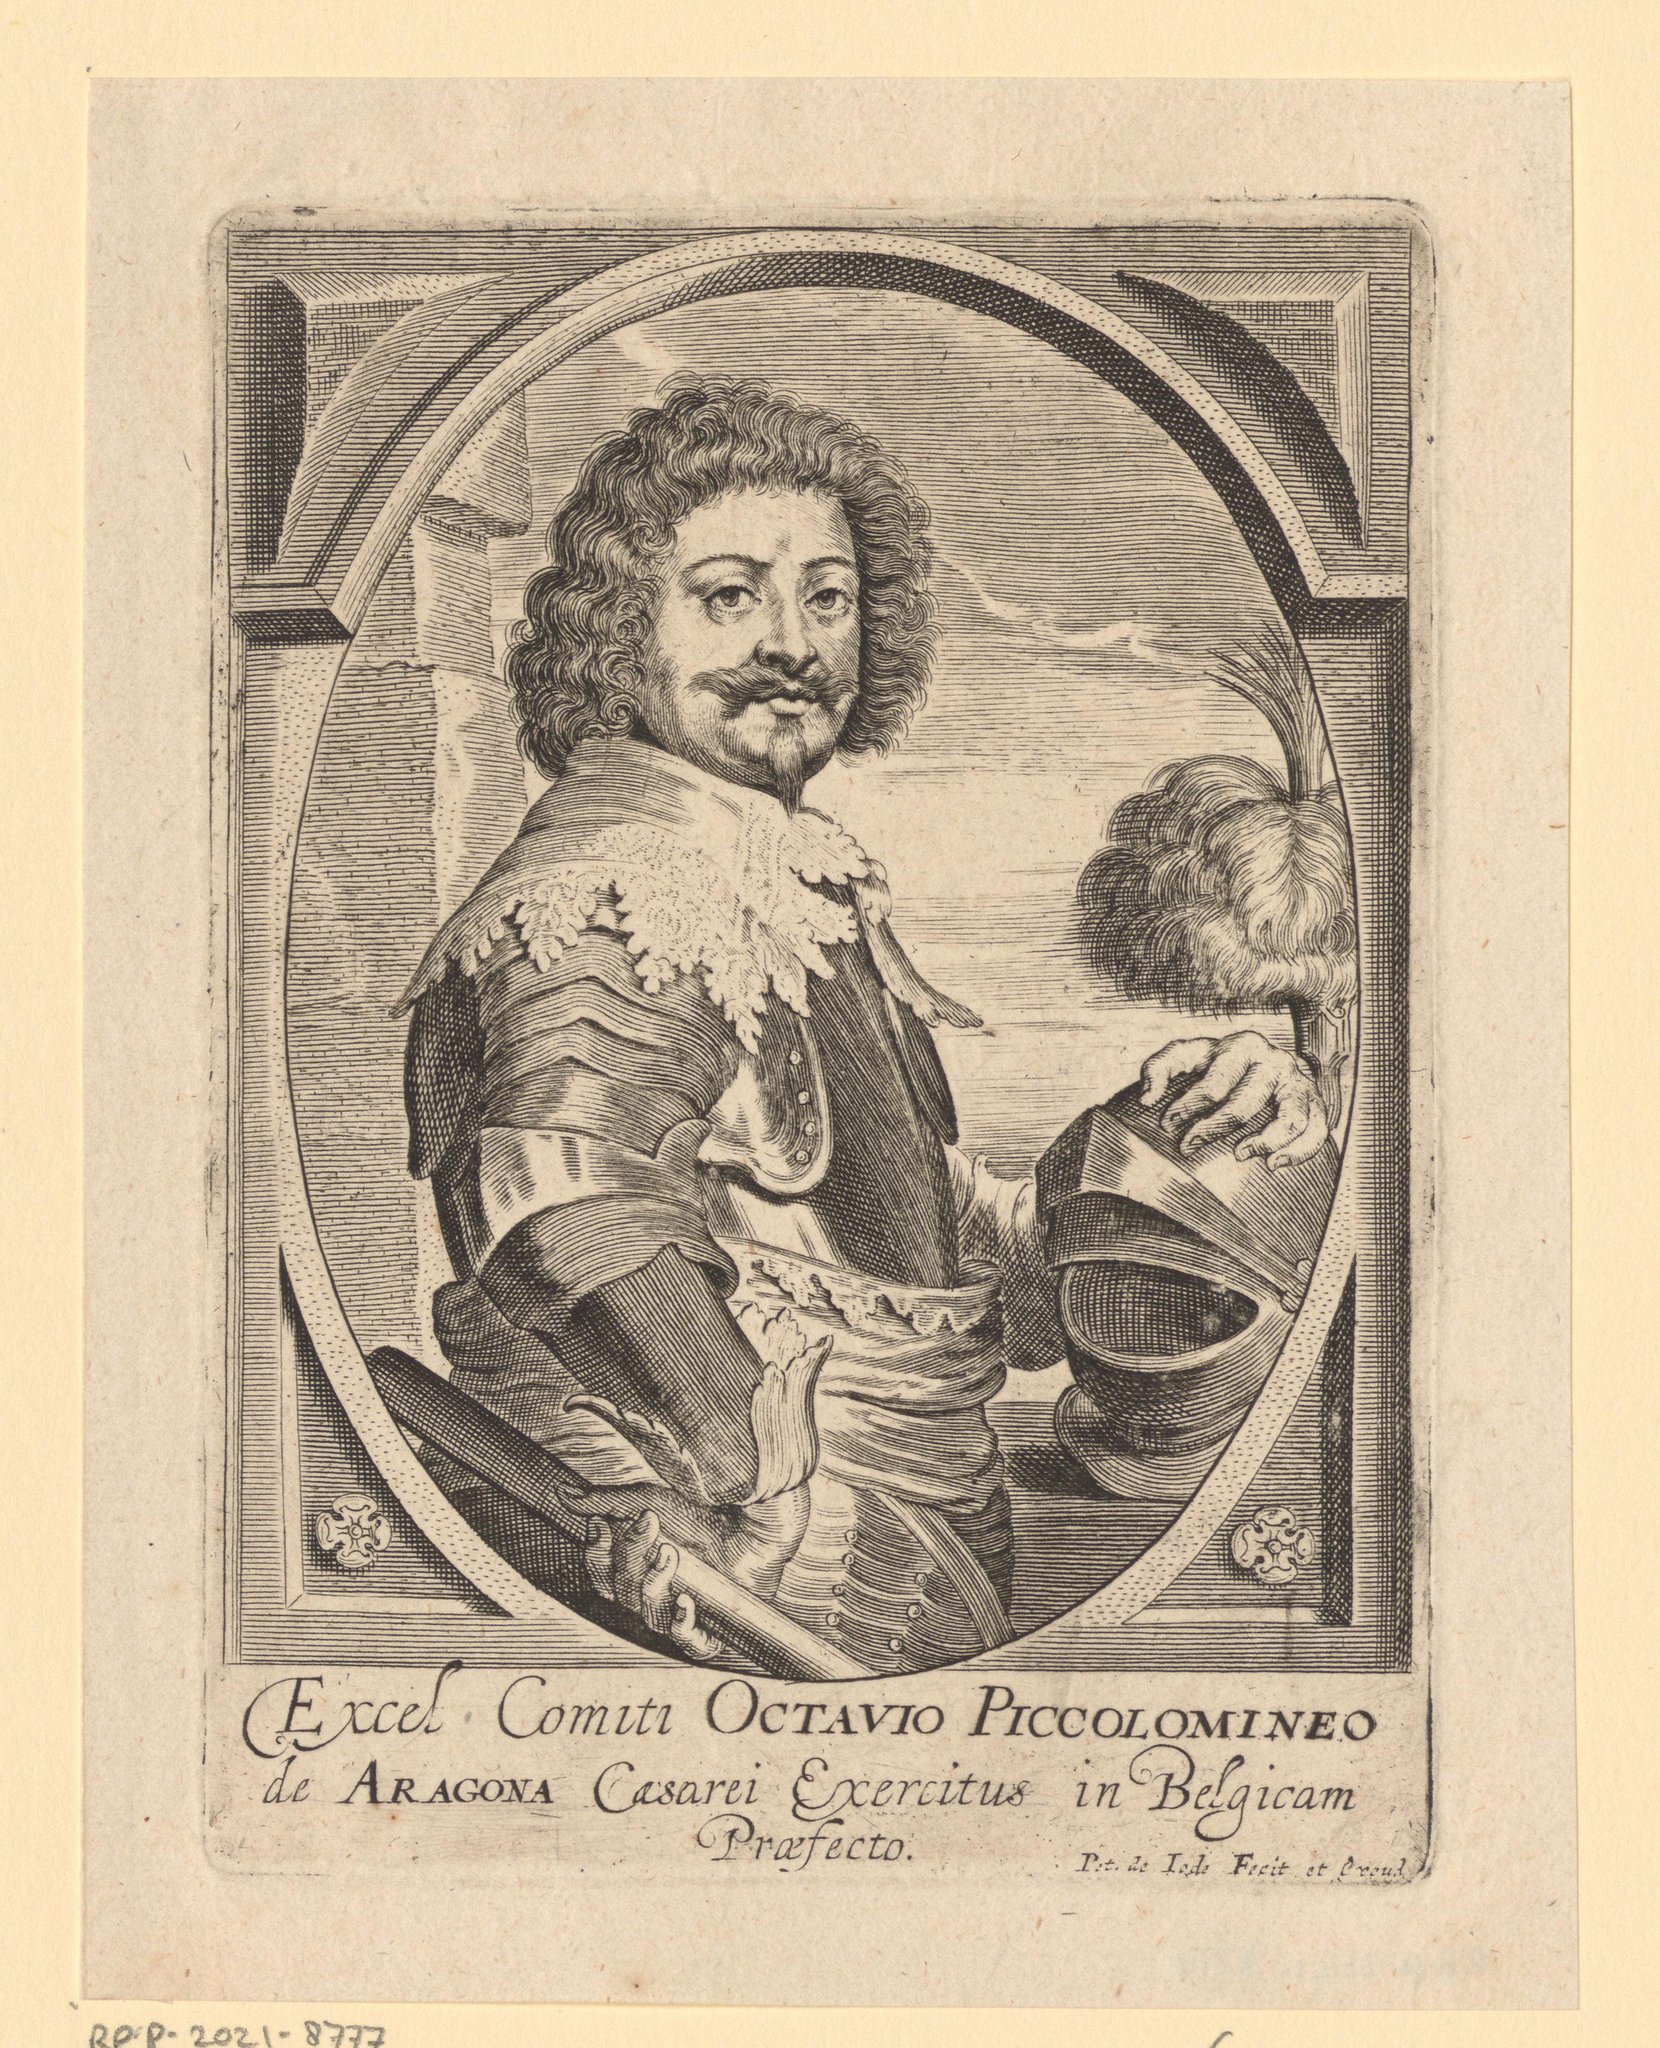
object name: print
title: Theater van bisschoppen, keizers, koningen, hertogen, prinsen, enz.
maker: pieter de jode (ii)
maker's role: draughtsman, print maker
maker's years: 1606-1674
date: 1638-1651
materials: paper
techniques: engraving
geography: antwerp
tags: adult man, historical persons, military clothing and other equipment (uniforms, cap, armour, helmet, etc.)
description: De prent is gebruikt voor De Jode's serie Theater van portretten (zie New Hollstein), tussen 1638 en 1651 uitgegeven onder de titel 'Theatrum Principum, Ducum et Comitum (...)' en 'Theatrum pontificum, imperatorum, regum, ducum, principum, etc.'.